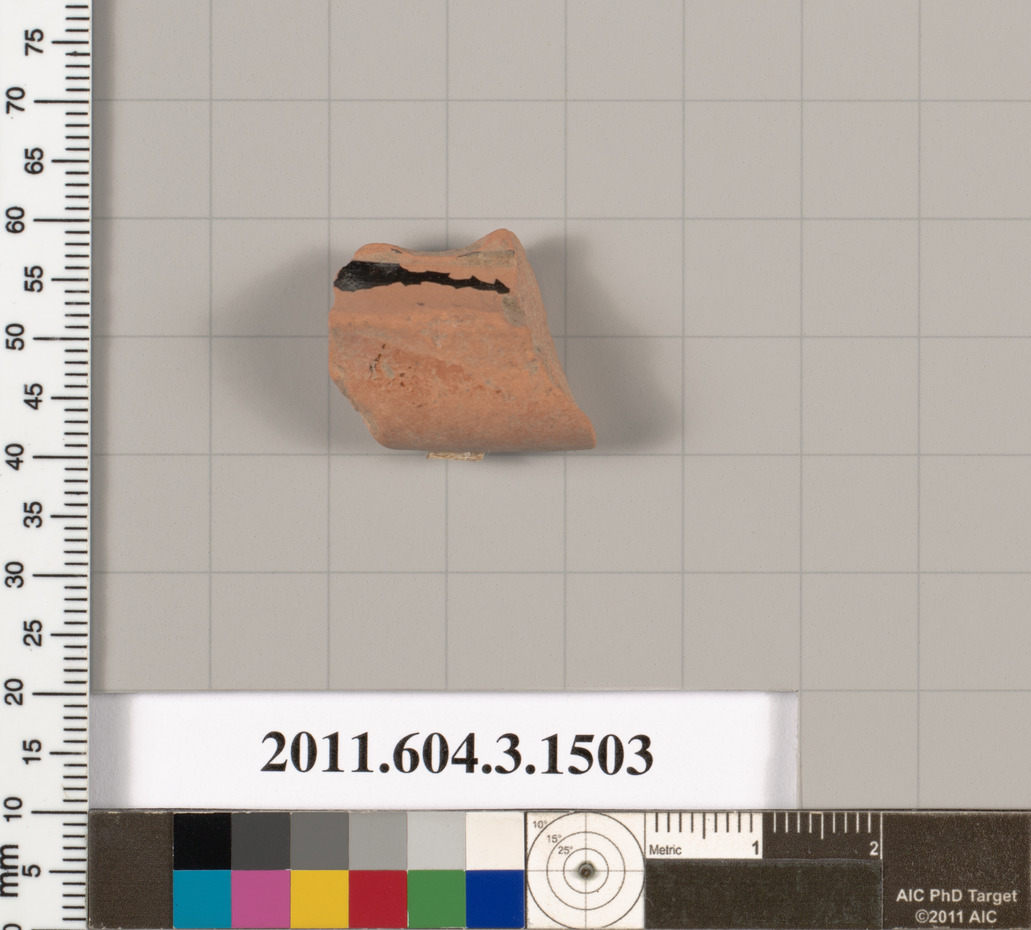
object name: skyphos fragment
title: Terracotta fragment of a skyphos (deep drinking cup)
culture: greek, attic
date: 600-401 BCE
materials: terracotta